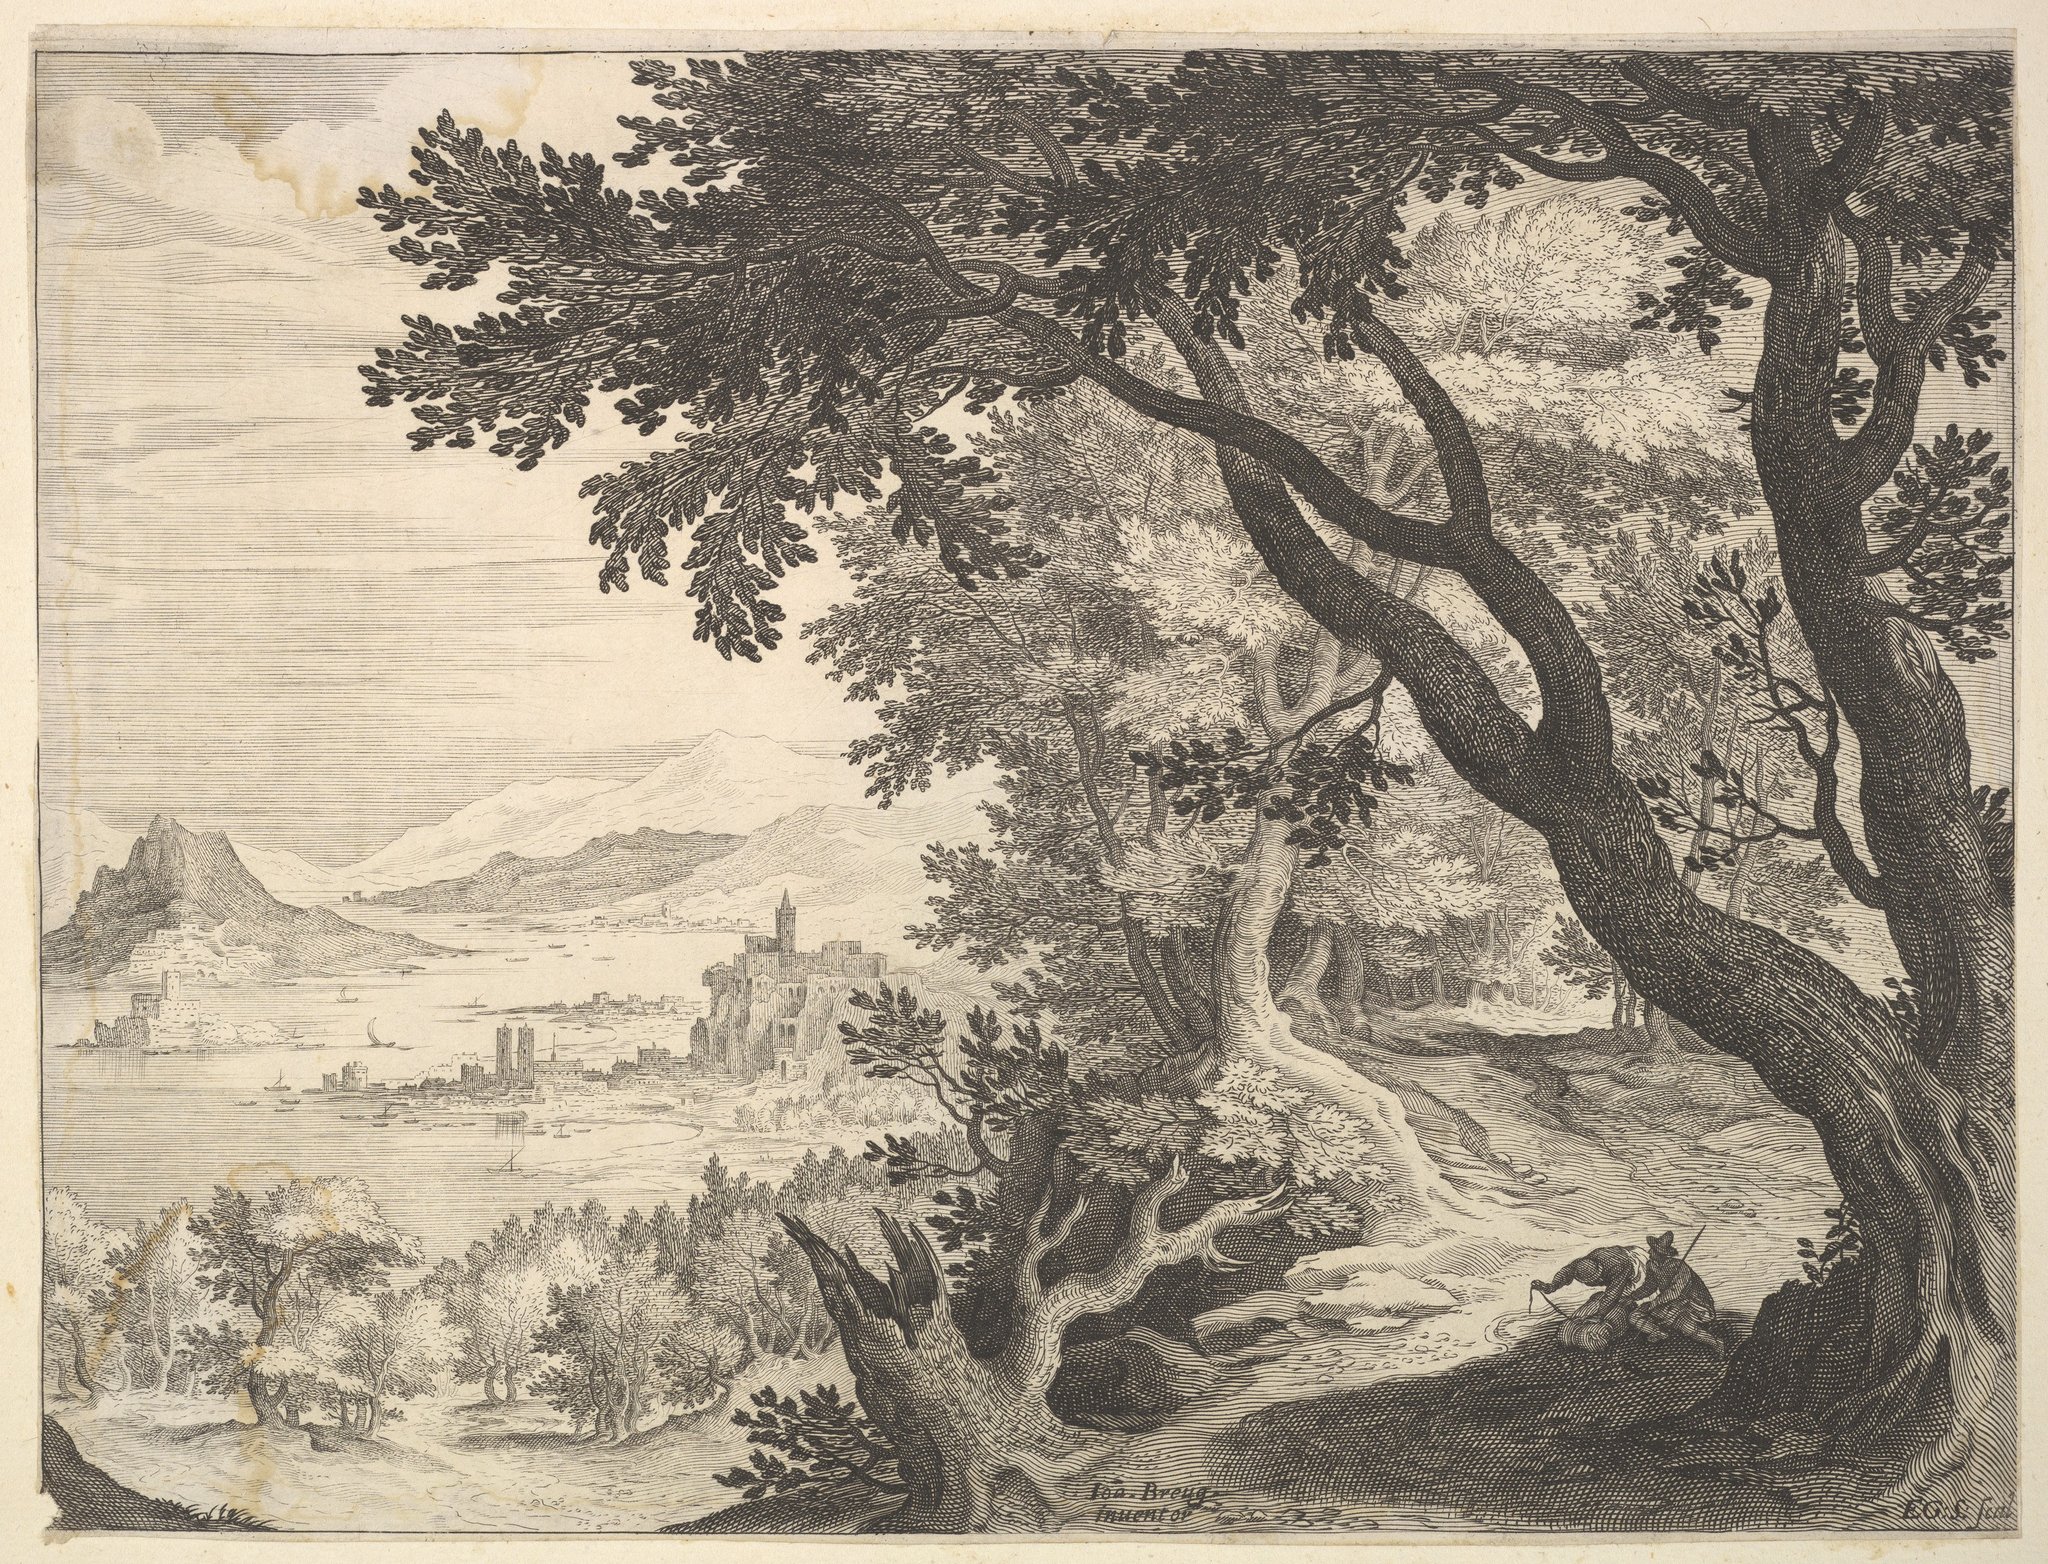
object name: print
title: Riverscape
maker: aegidius sadeler (ii)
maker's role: artist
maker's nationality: flemish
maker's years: 1568-1629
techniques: engraving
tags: men,rivers,landscapes,trees